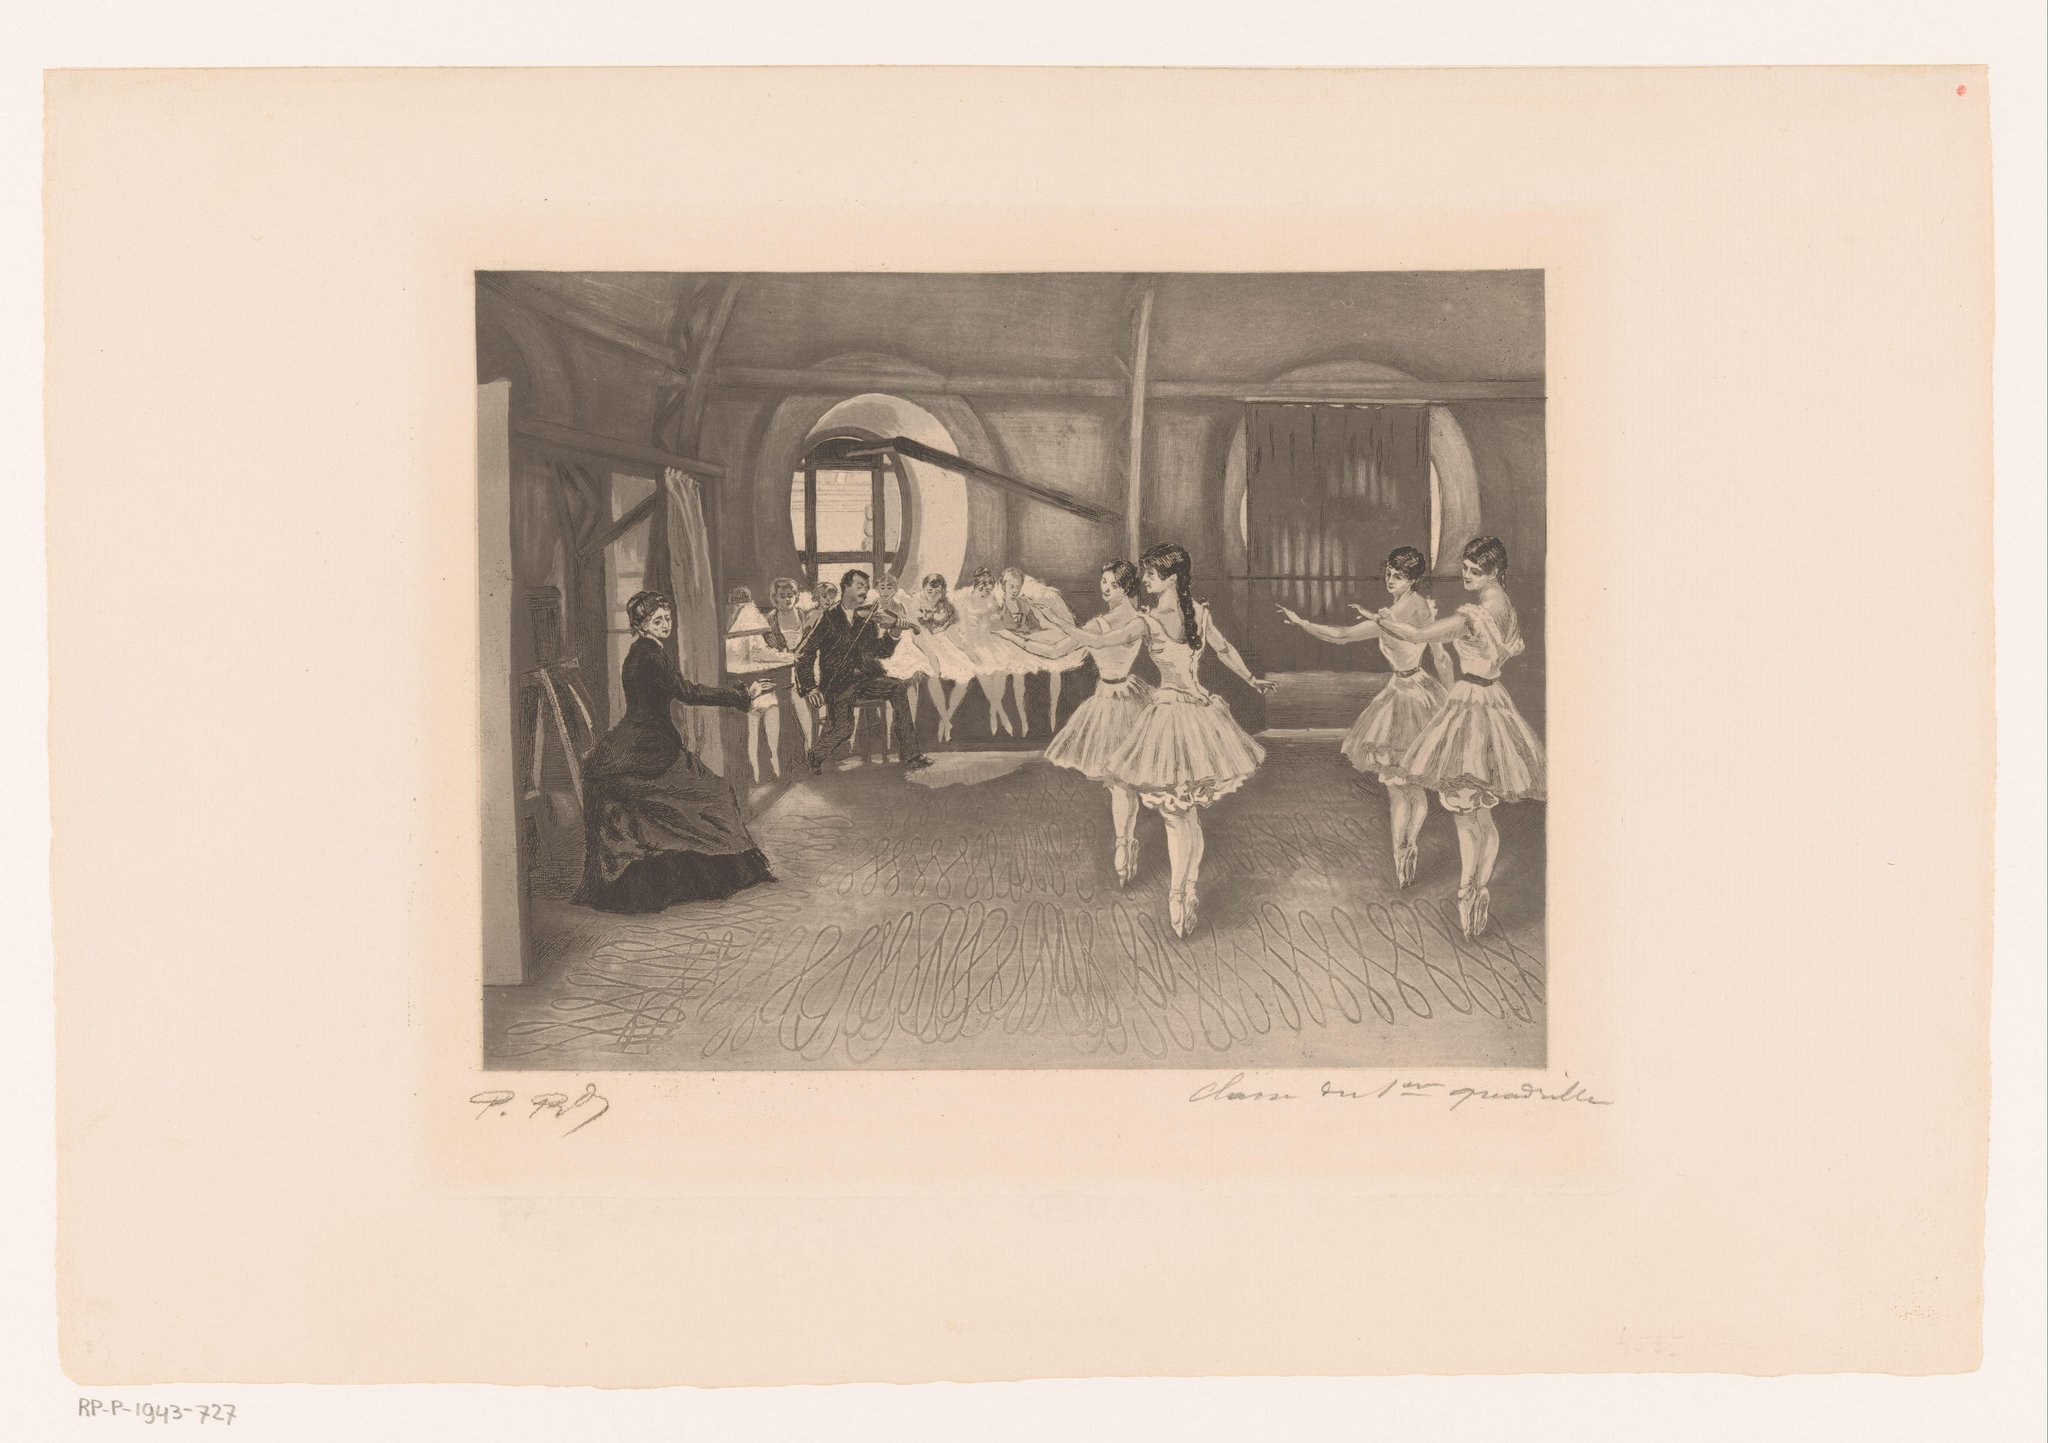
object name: print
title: Balletles in zaal met violist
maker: paul renouard (1845-1924)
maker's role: painter, print maker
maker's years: 1845-1924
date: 1855-1924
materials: paper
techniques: aquatint, etching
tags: the ballet, ballet performance, violin, fiddle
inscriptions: collector's mark: Lugt 2228